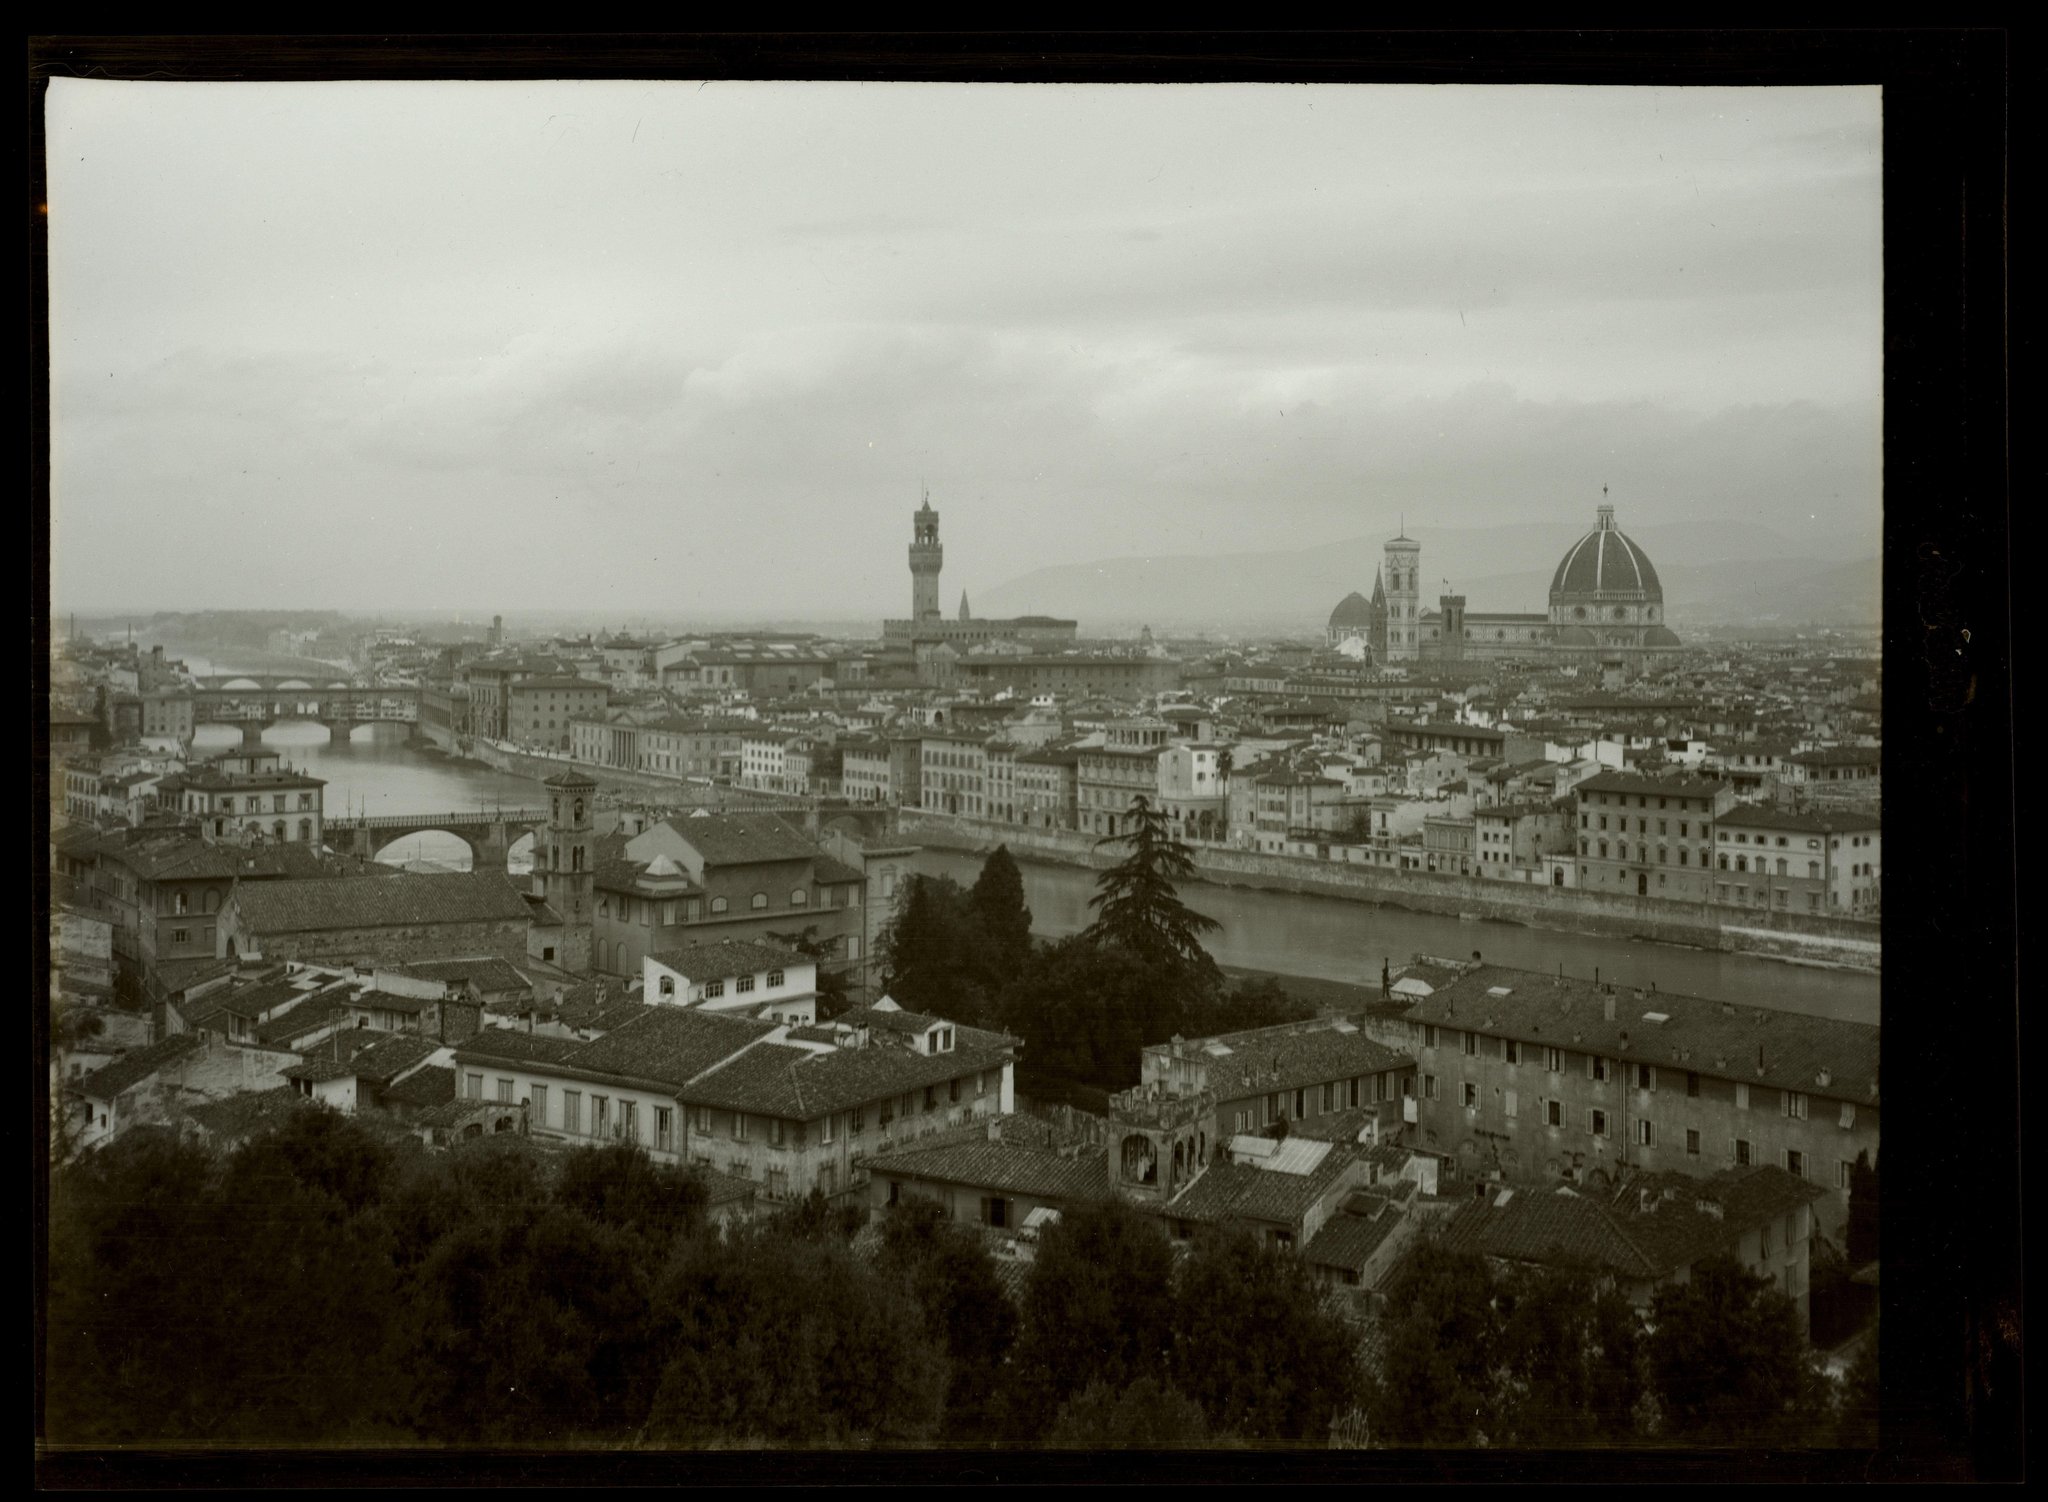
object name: photograph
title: Filmnegatief met opname van Florence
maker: Anonymous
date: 1907-1935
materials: film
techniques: gelatin silver negative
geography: florence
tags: florence